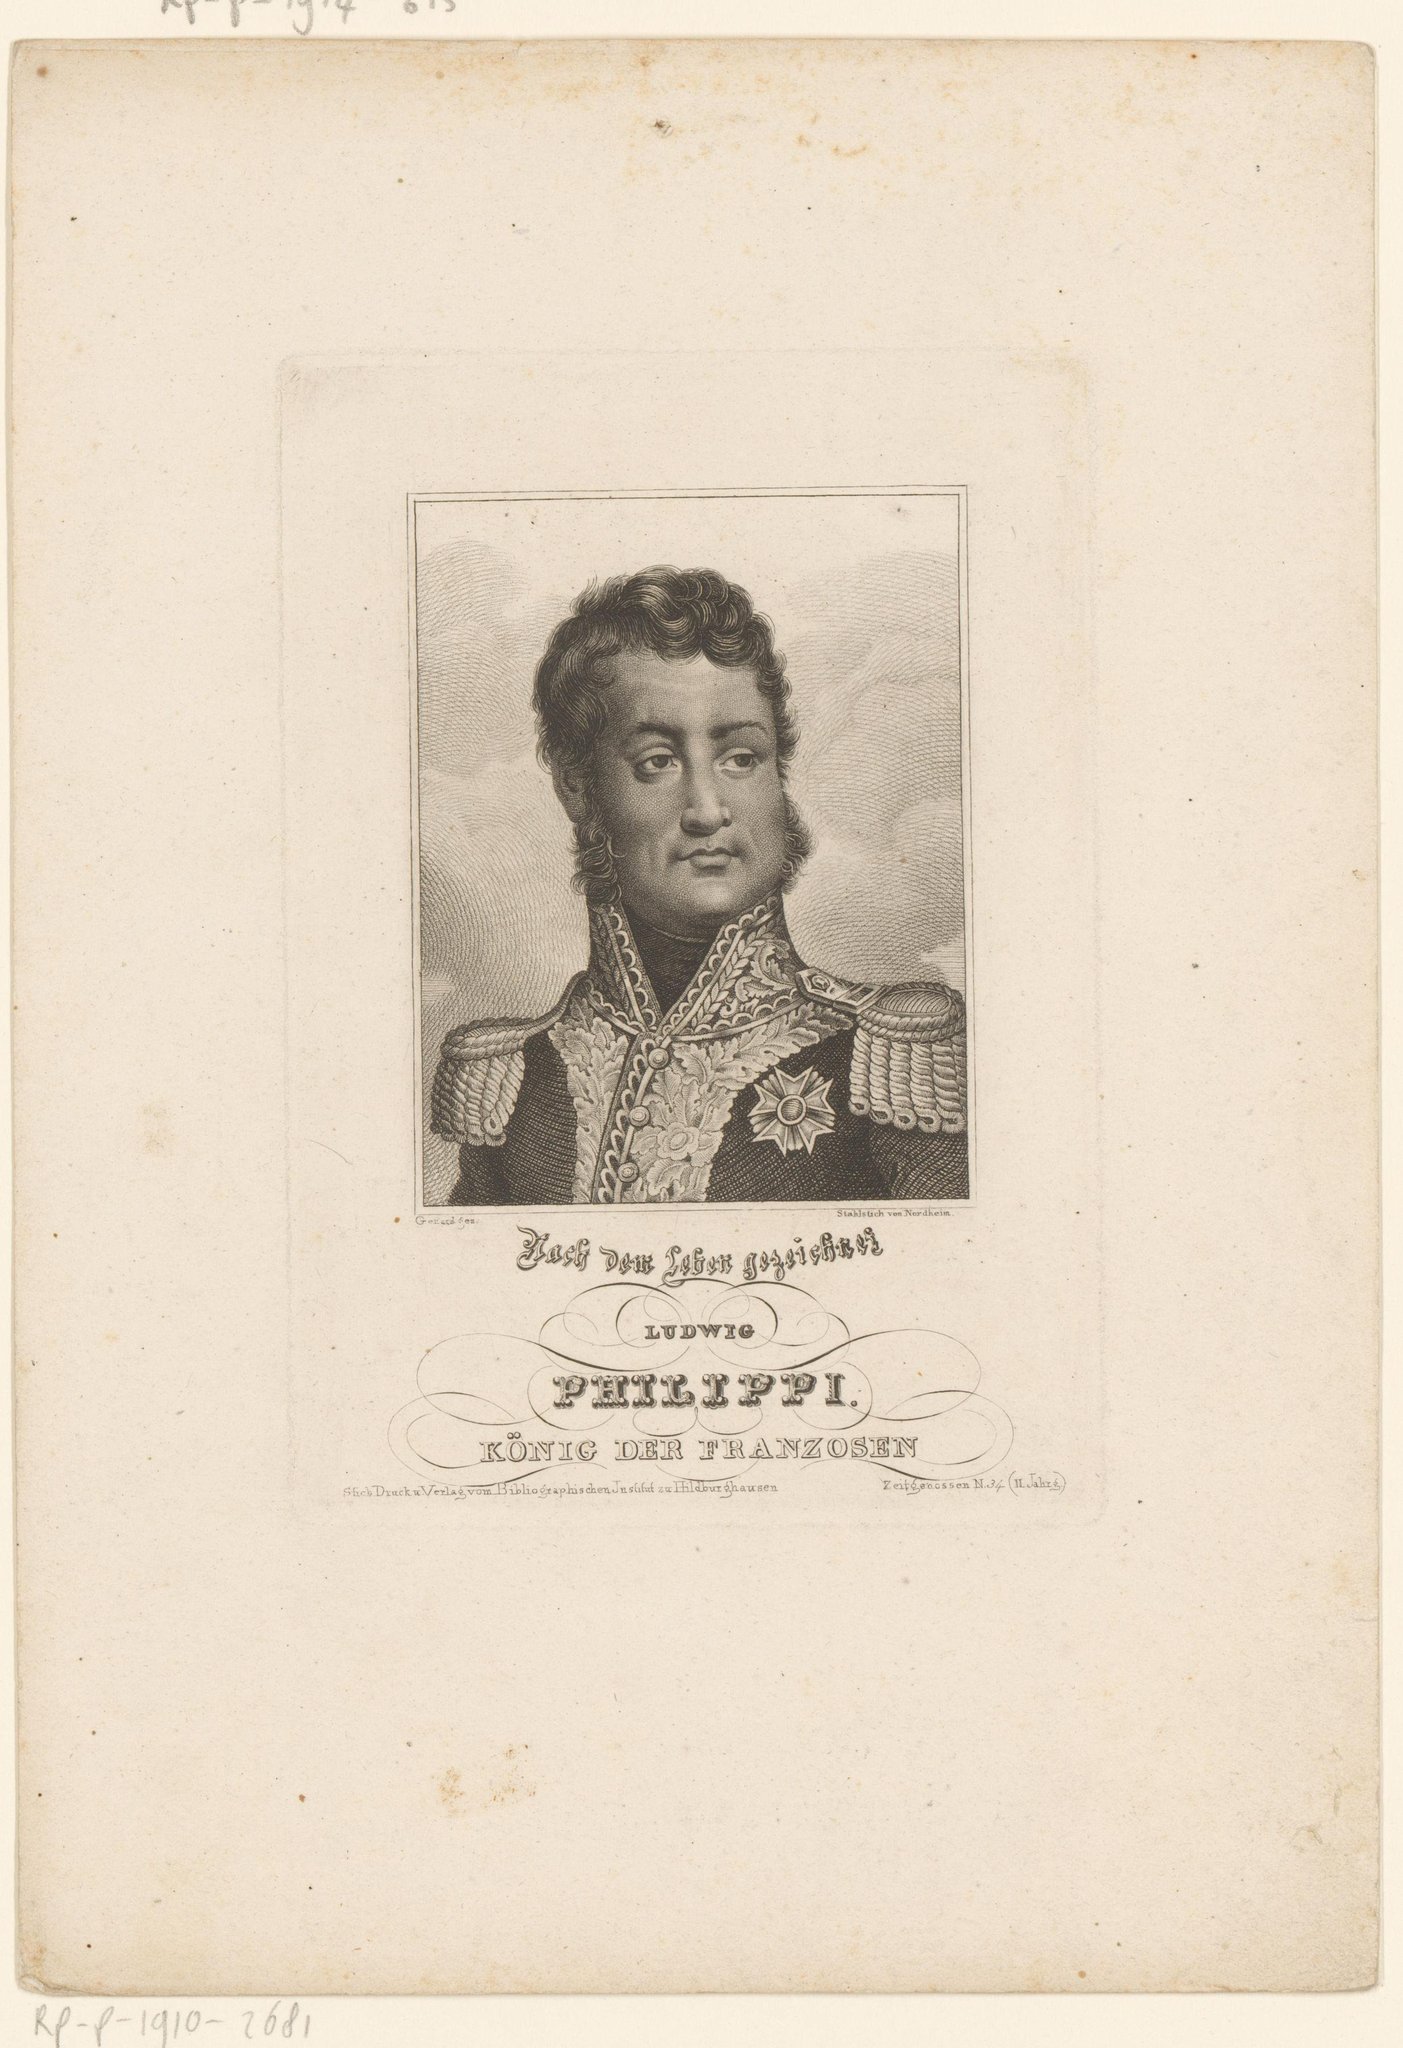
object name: print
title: Portret van Lodewijk Filips I, koning van Frankrijk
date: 1829-1840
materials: paper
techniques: engraving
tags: paris, lodewijk filips i (koning van frankrijk), historical persons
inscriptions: collector's mark: Lugt 2228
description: Afkomstig uit de portretserie 'Zeitgenossen', uitgegeven tussen 1829 en circa 1840.